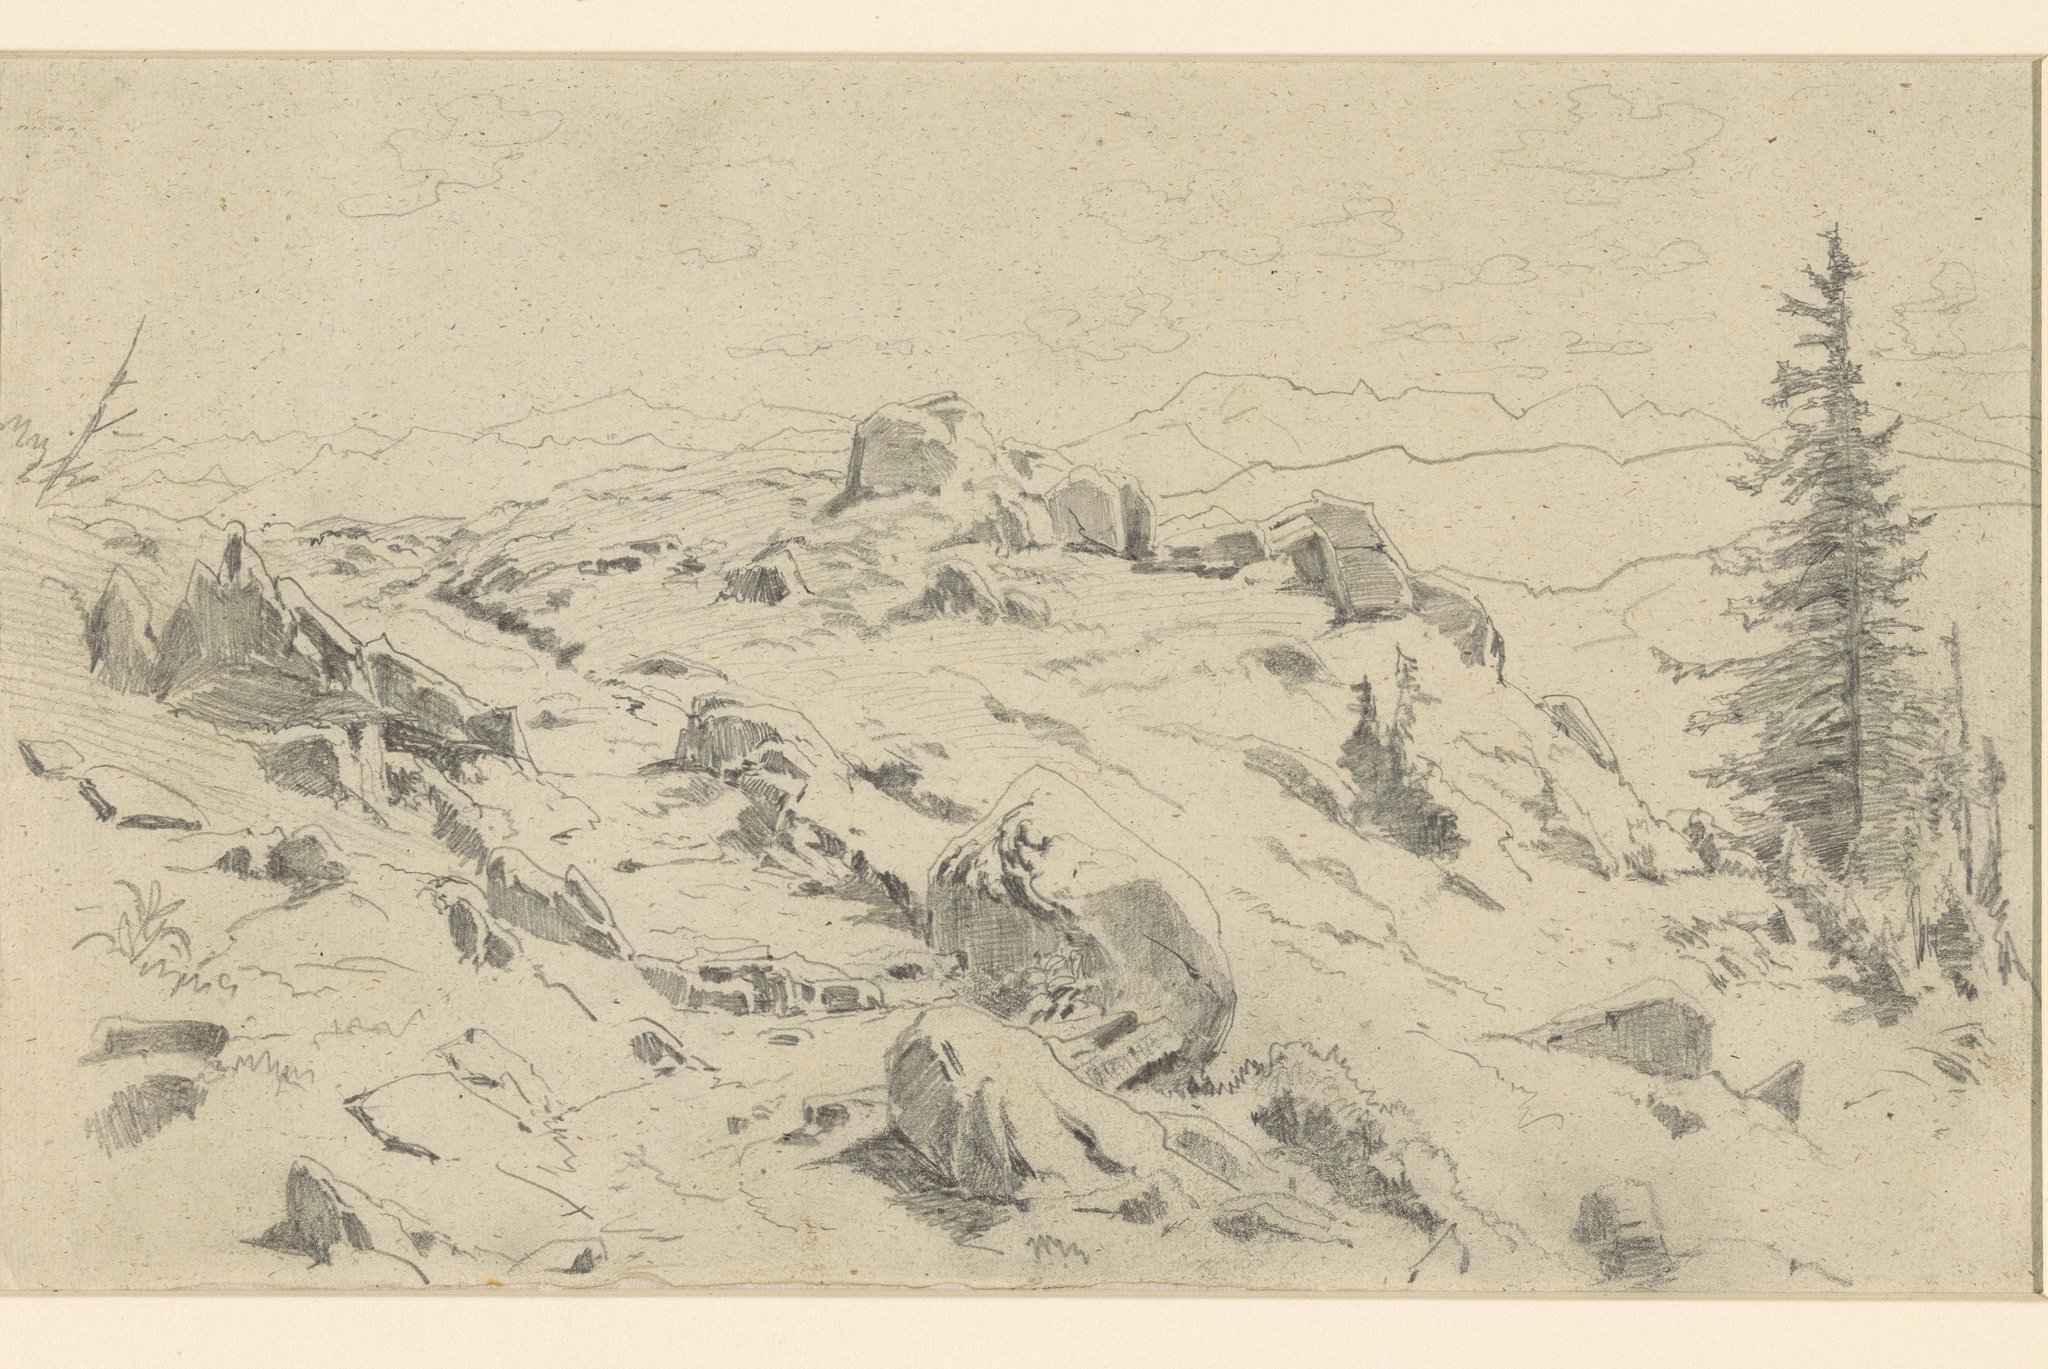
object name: drawing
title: Rotsblokken en dennen in het hooggebergte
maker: ludwig gustav voltz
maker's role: draughtsman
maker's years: 1825-1911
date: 1835-1911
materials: paper, pencil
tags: rocks